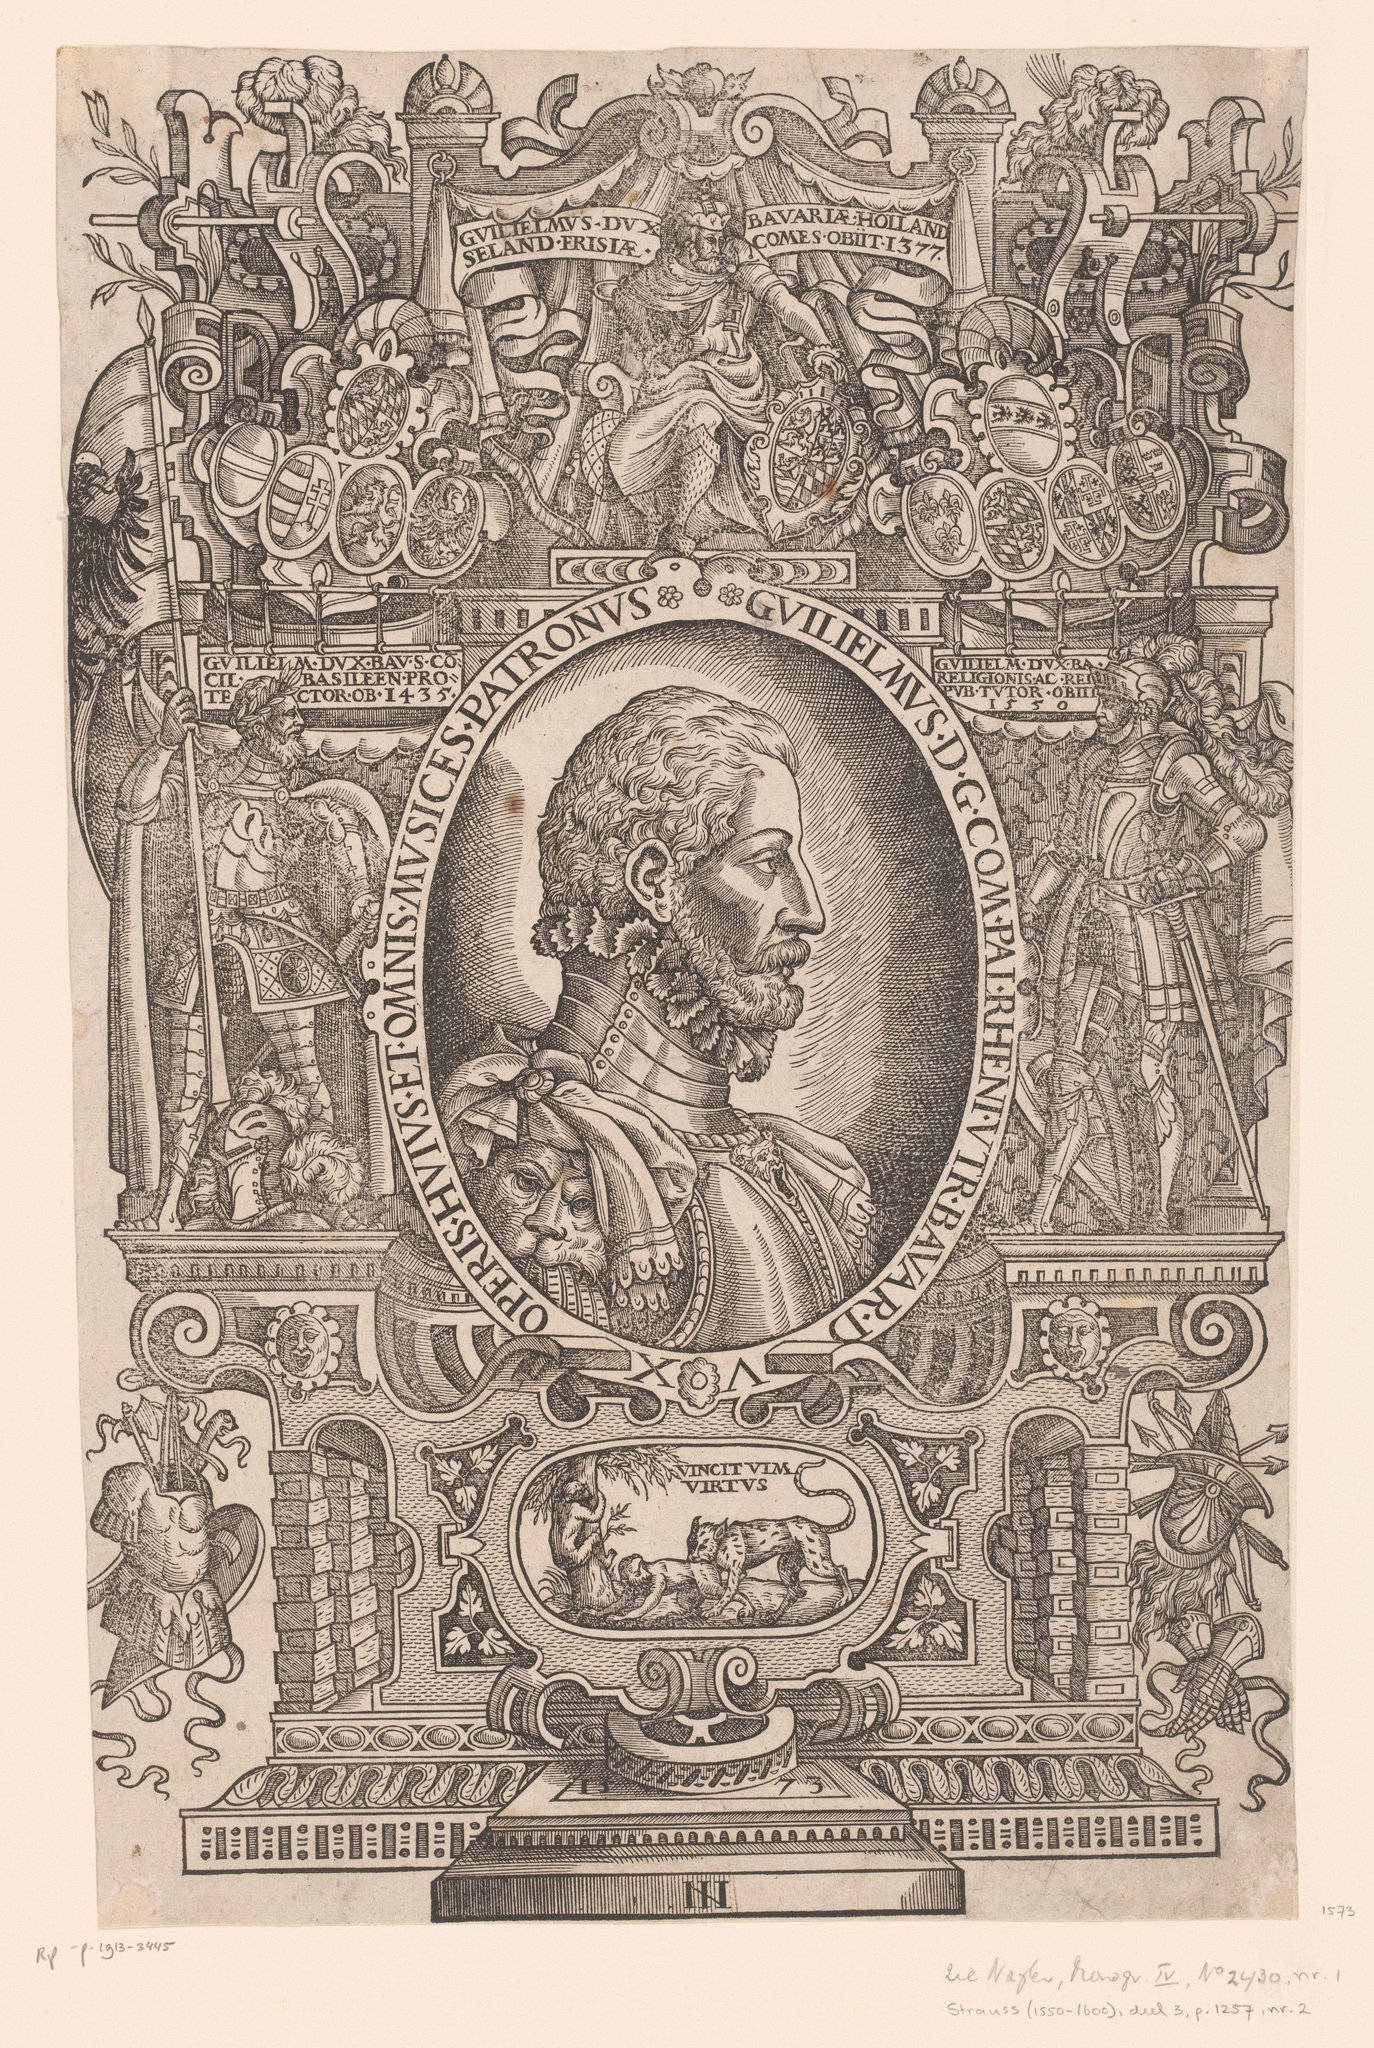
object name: print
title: Portret van Willem V van Beieren in genealogisch kader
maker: Anonymous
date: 1573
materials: paper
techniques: woodcut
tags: schleissheim, willem v van beieren, historical persons, family lineage, pedigree, genealogical tree or table, armorial bearing, heraldry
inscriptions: collector's mark: Lugt 2228